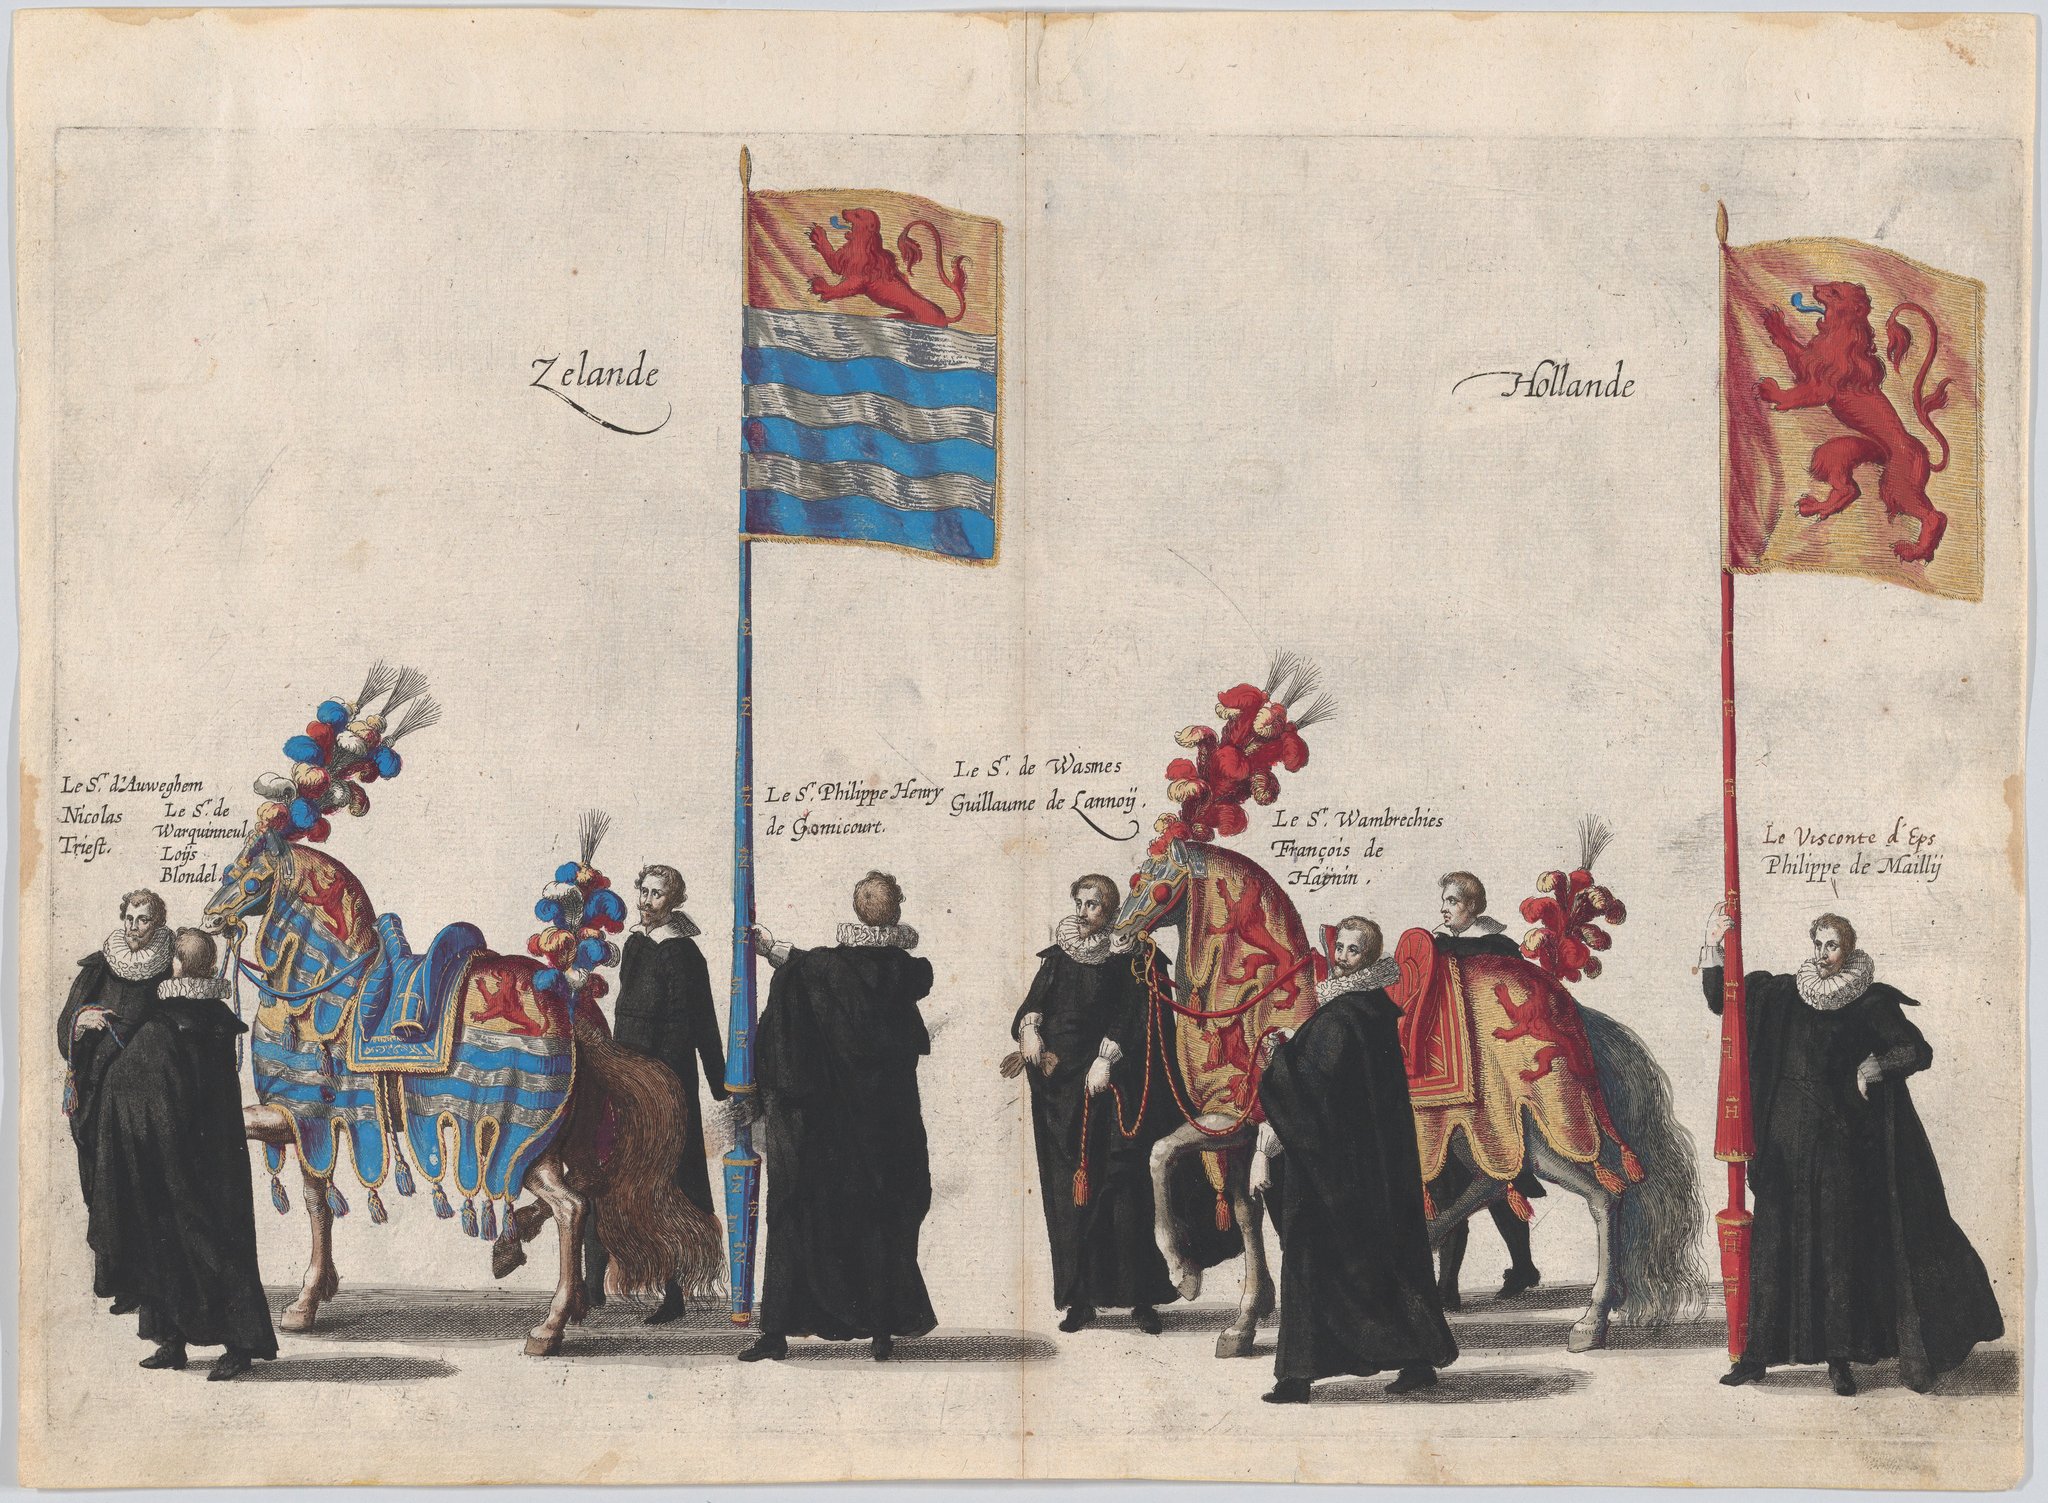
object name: print, fete, ornament architecture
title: Plate 37: Men with heraldic flags and horses from Zeeland and Holland marching in the funeral procession of Archduke Albert of Austria; from 'Pompa Funebris ... Alberti Pii'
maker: cornelis galle (i)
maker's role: artist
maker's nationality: netherlandish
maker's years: 1576-1650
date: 1623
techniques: etching, hand coloring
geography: brussels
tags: men,horses,flags